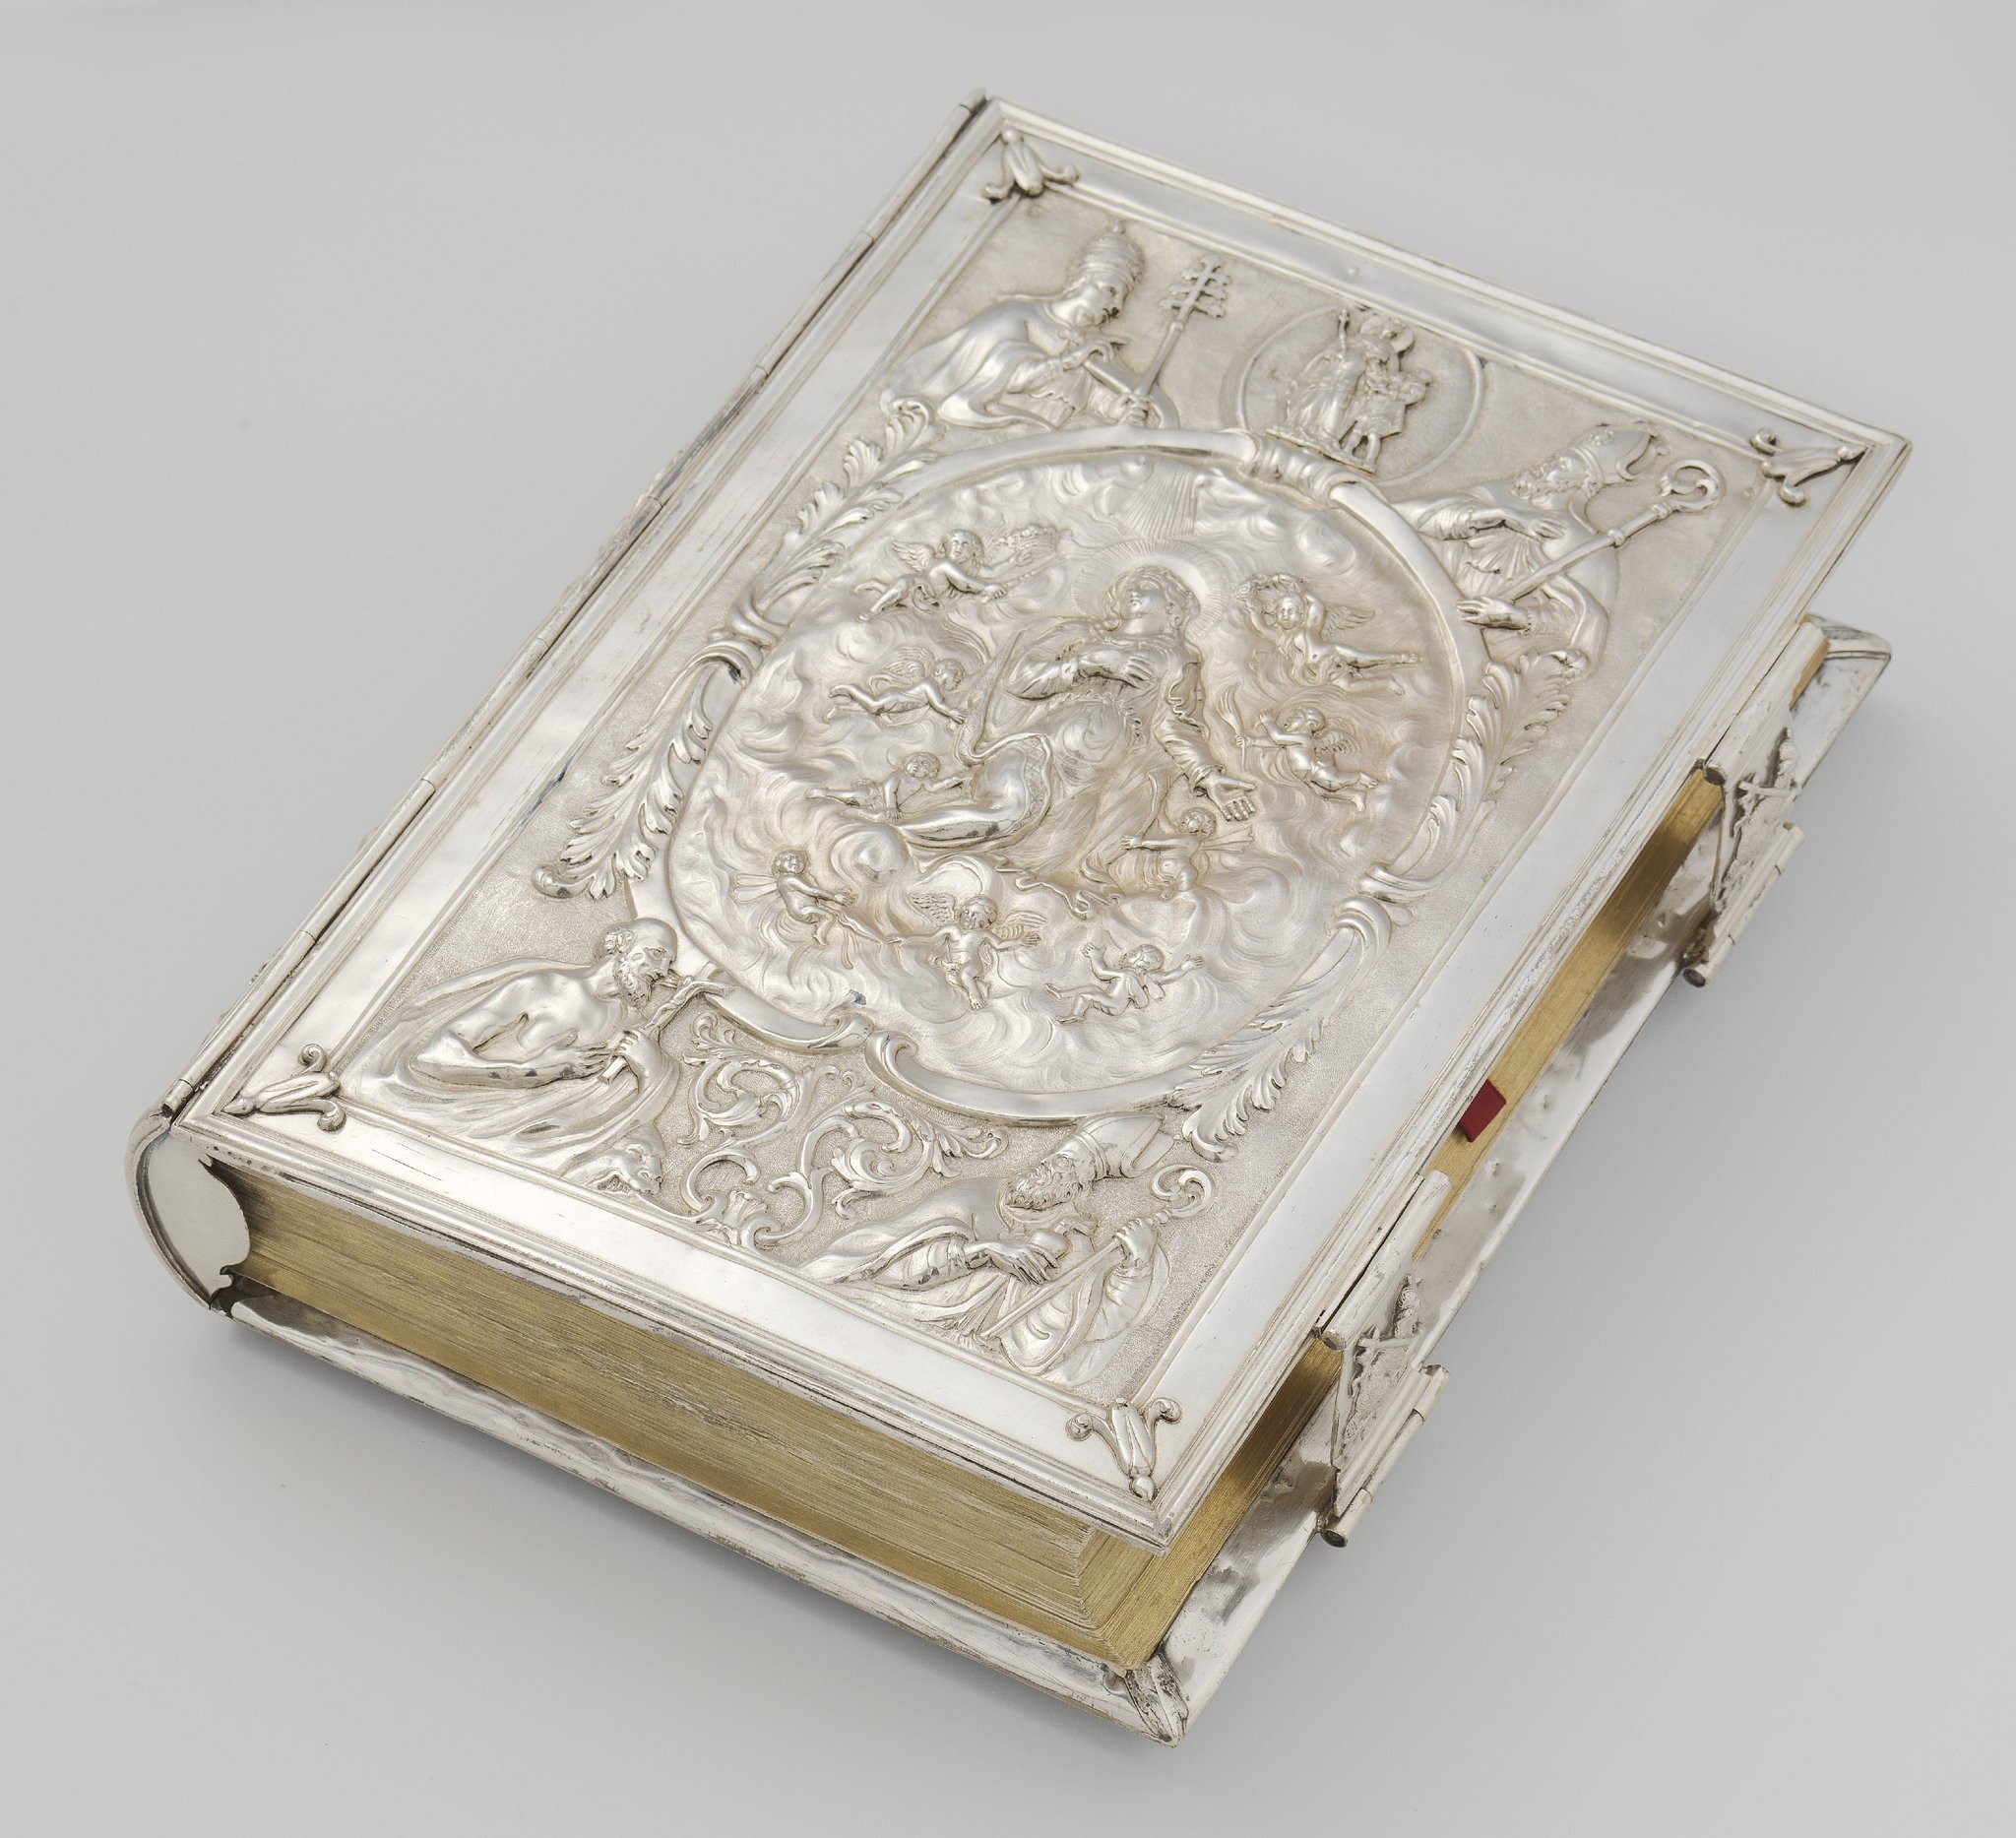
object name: missaalband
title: Missal cover with the Ascension of the Virgin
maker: david roobol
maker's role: silversmith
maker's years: 1705-1749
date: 1738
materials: silver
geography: amsterdam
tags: the ascension (christ surrounded by radiant light or in a mandorla), last supper (in general) (matthew 26:21-35; mark 14:18-31; luke 22:3, 22:15-23; john 13:21-38)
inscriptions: maker's mark: ‘ooievaar in schild’, date letter: ‘D’, town mark, alloy mark: ‘Hollandse leeuw’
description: The Bible is the most important source of inspiration for all Christians. How it was interpreted by the different religious denominations can be deduced from the book’s ornamentation and execution. The scenes on the cover of this missal, for example, are clearly Roman Catholic. Represented in the corners are the Church Fathers, who are venerated by Catholics as the founders of the Christian faith. The Virgin is also central, both on this cover and in Catholic doctrine.